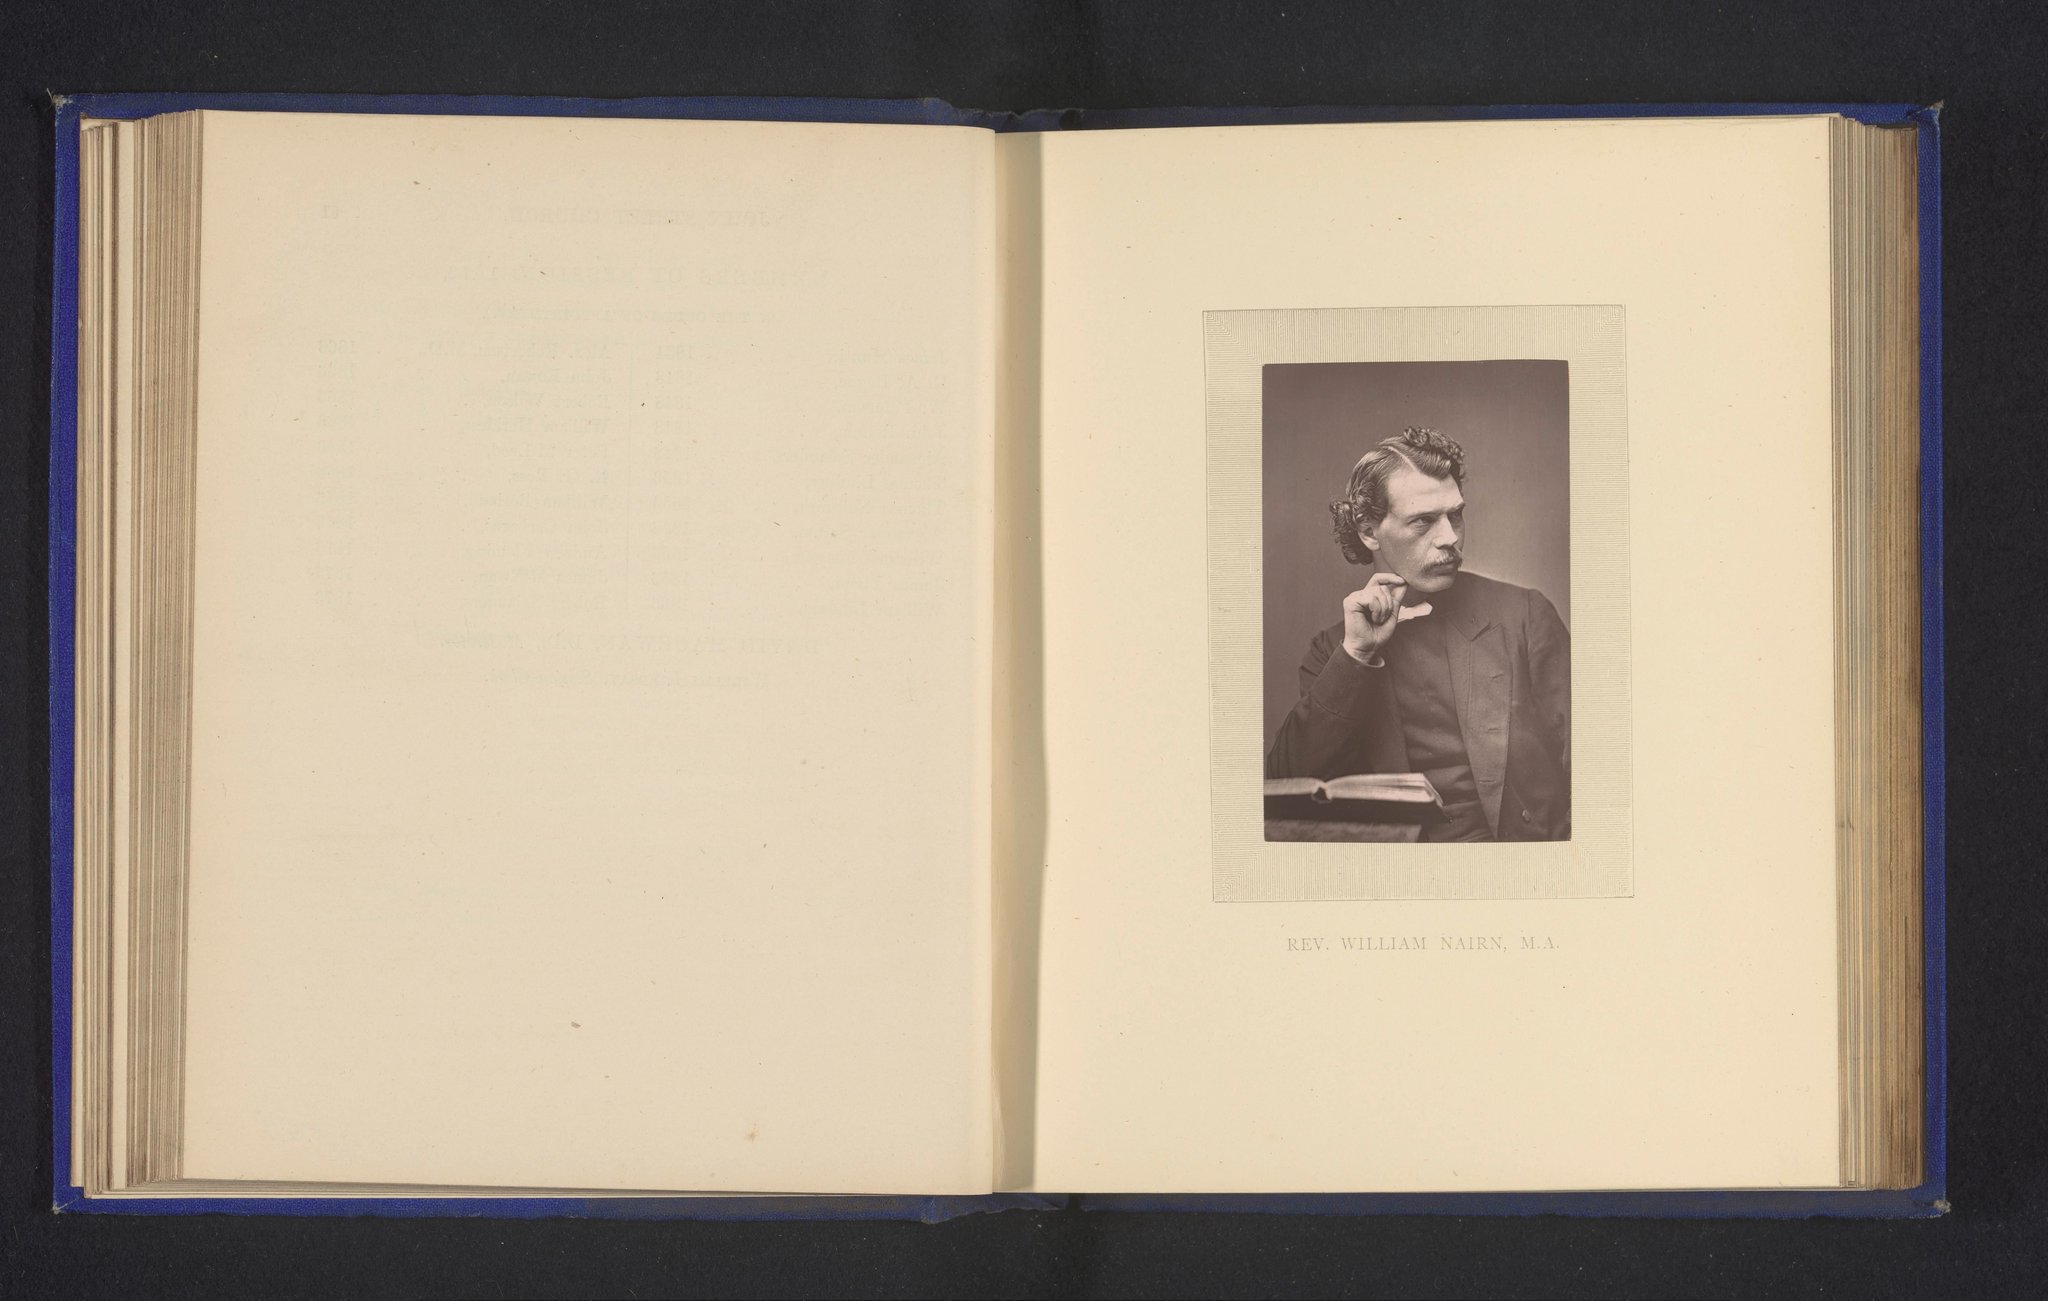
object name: page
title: Portret van William Nairn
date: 1865-1875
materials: paper, photographic support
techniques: carbon print, woodburytype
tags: functionaries and dignitaries (with name) ~ protestant churches